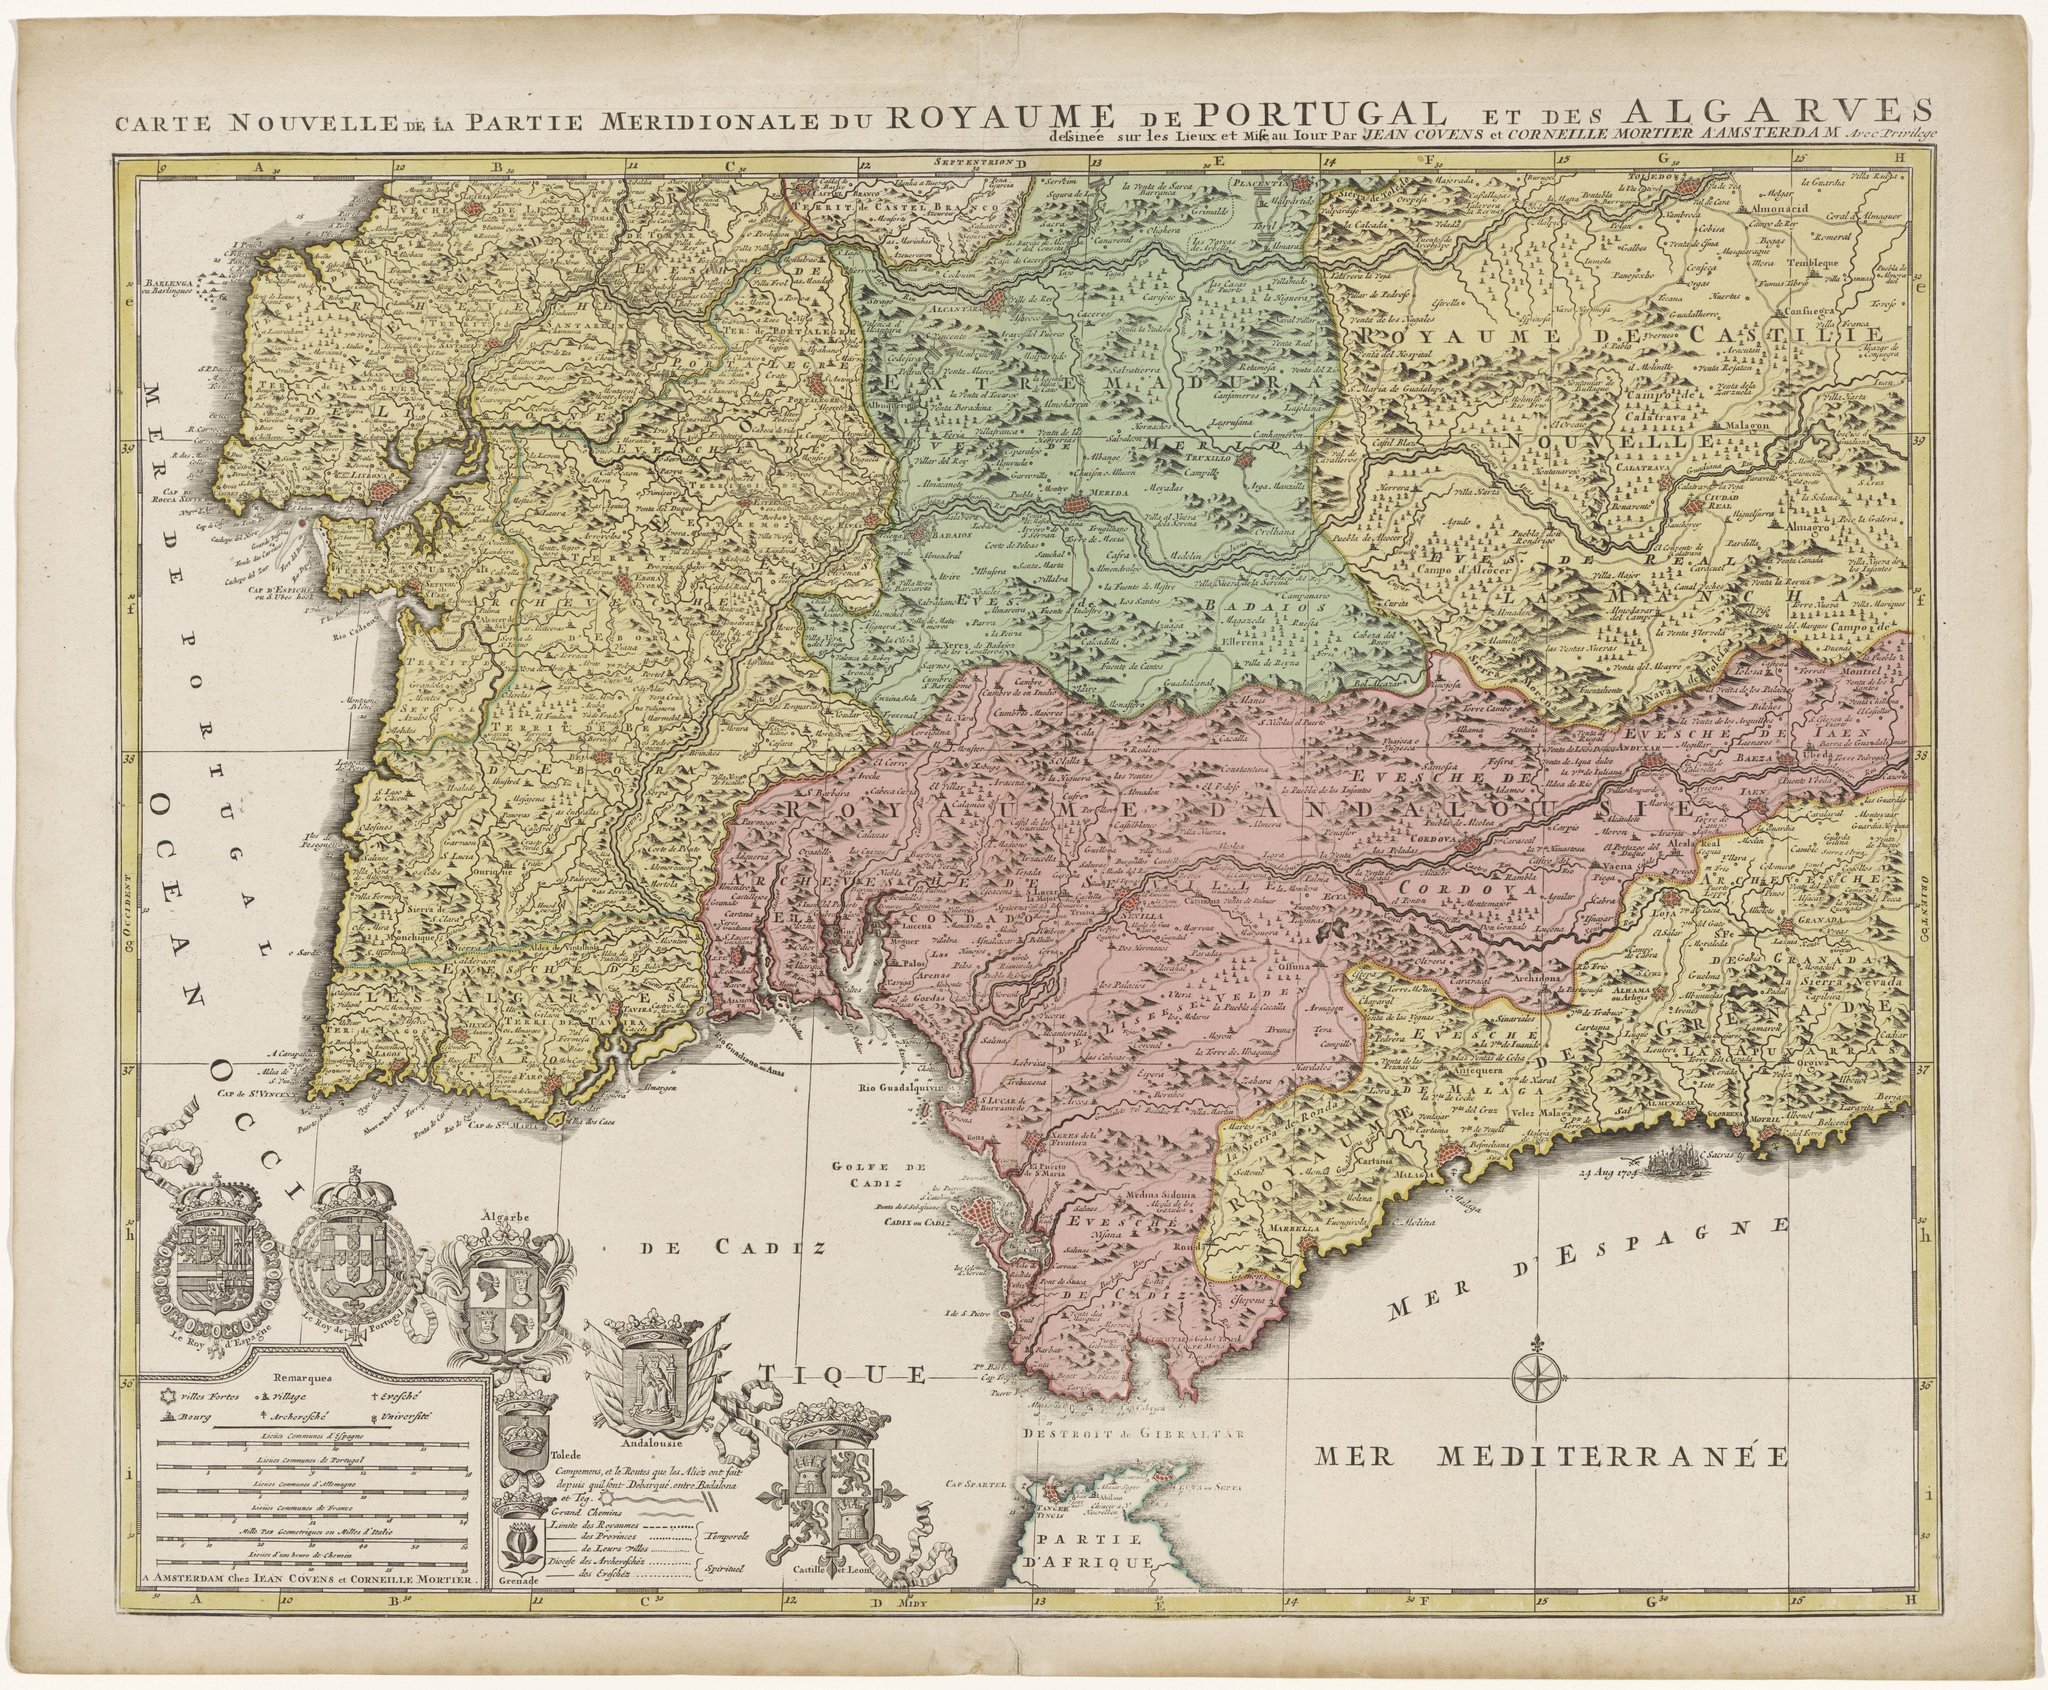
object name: print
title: Kaart van het zuiden van Spanje en Portugal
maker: Anonymous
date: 1720-1772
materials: paper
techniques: engraving, etching, hand coloring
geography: amsterdam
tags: maps of separate countries or regions, flag, colours (as symbol of the state, etc.), spain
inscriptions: collector's mark: Lugt 2228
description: Kaart met een deel van Portugal en de Spaanse zuidkust. Onderdeel (blad linksonder) van een grote kaart van Spanje en Portugal in vier bladen, ca. 1703. Linksonder de legenda en de wapens van Spanje en Portugal, verbonden met de wapens van de Algarve (waaronder de stadswapens van Toledo en Grenada hangen), Andalusië en Castilië en León.